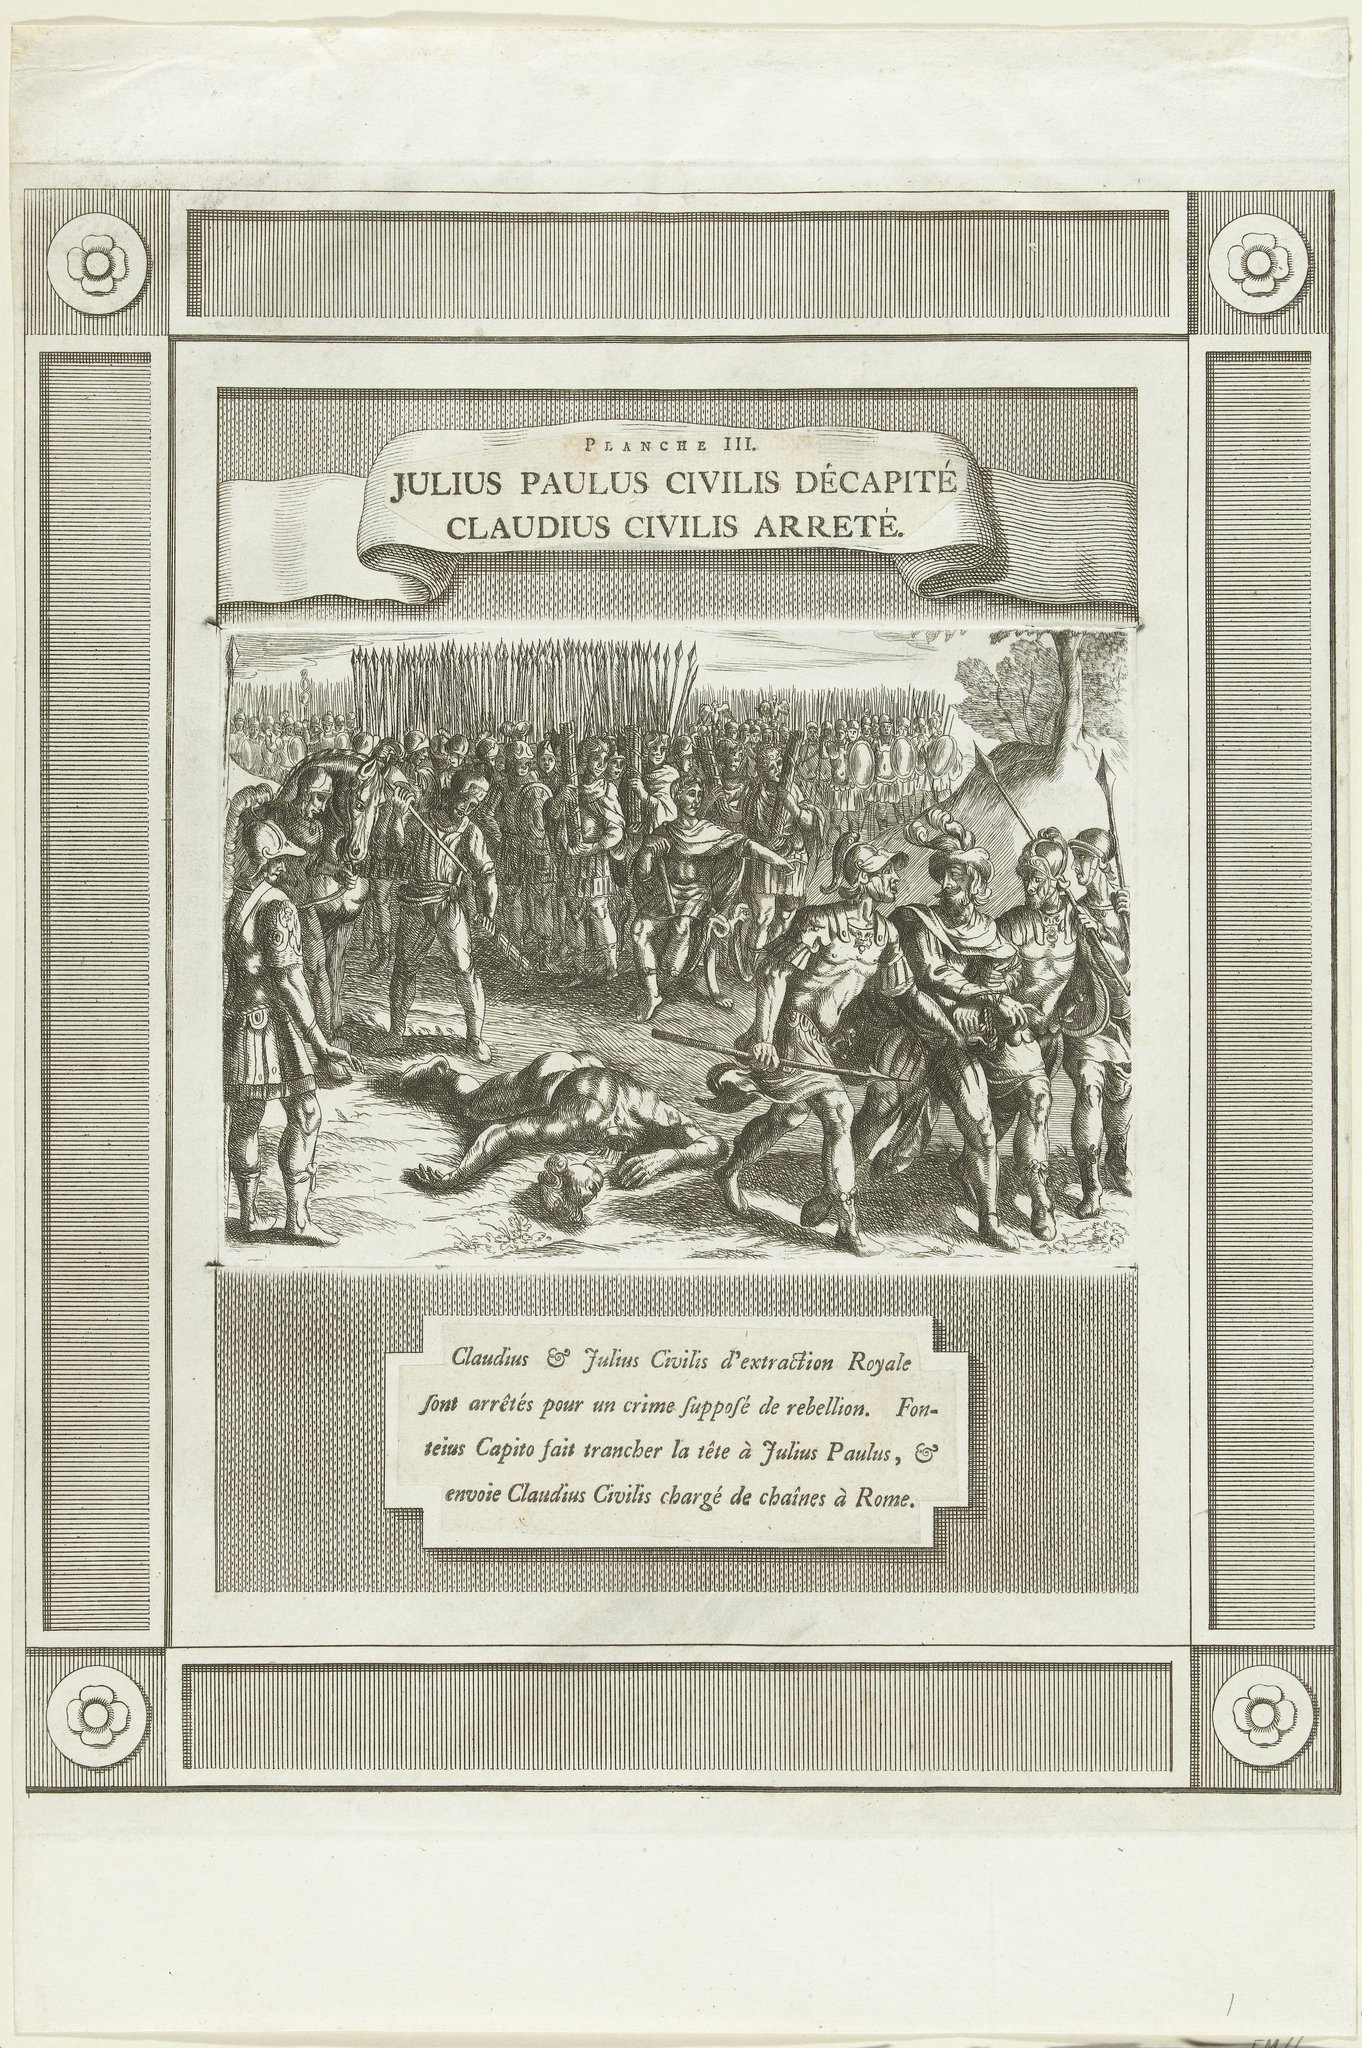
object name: history print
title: Julius Paulus Civilis décapité, Claudius Civilis arreté / planche III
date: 1768-1770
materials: paper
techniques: engraving, etching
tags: extinct, 'historical' peoples (with name), netherlands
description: Claudius Civilis wordt gevangengenomen en zijn broer Paulus onthoofd. Prent 3 in een serie over de Bataafse Opstand, gekopieerd naar de reeks Batavorum cum Romanis bellum van Antonio Tempesta (Otto Vaenius, Antwerpen 1612). Illustratie voor: Marquis de St. Simon, Histoire de la guerre des Bataves et des Romains, d'après César; Corneille Tacite, Aux dépens de Marc-Michel Rey, Amsterdam 1770. Voorstellingen gedrukt in een grote ornamentele omlijsting waarin bovenaan een uitgeknipte titel en onderaan een onderschrift in het Frans is geplakt.